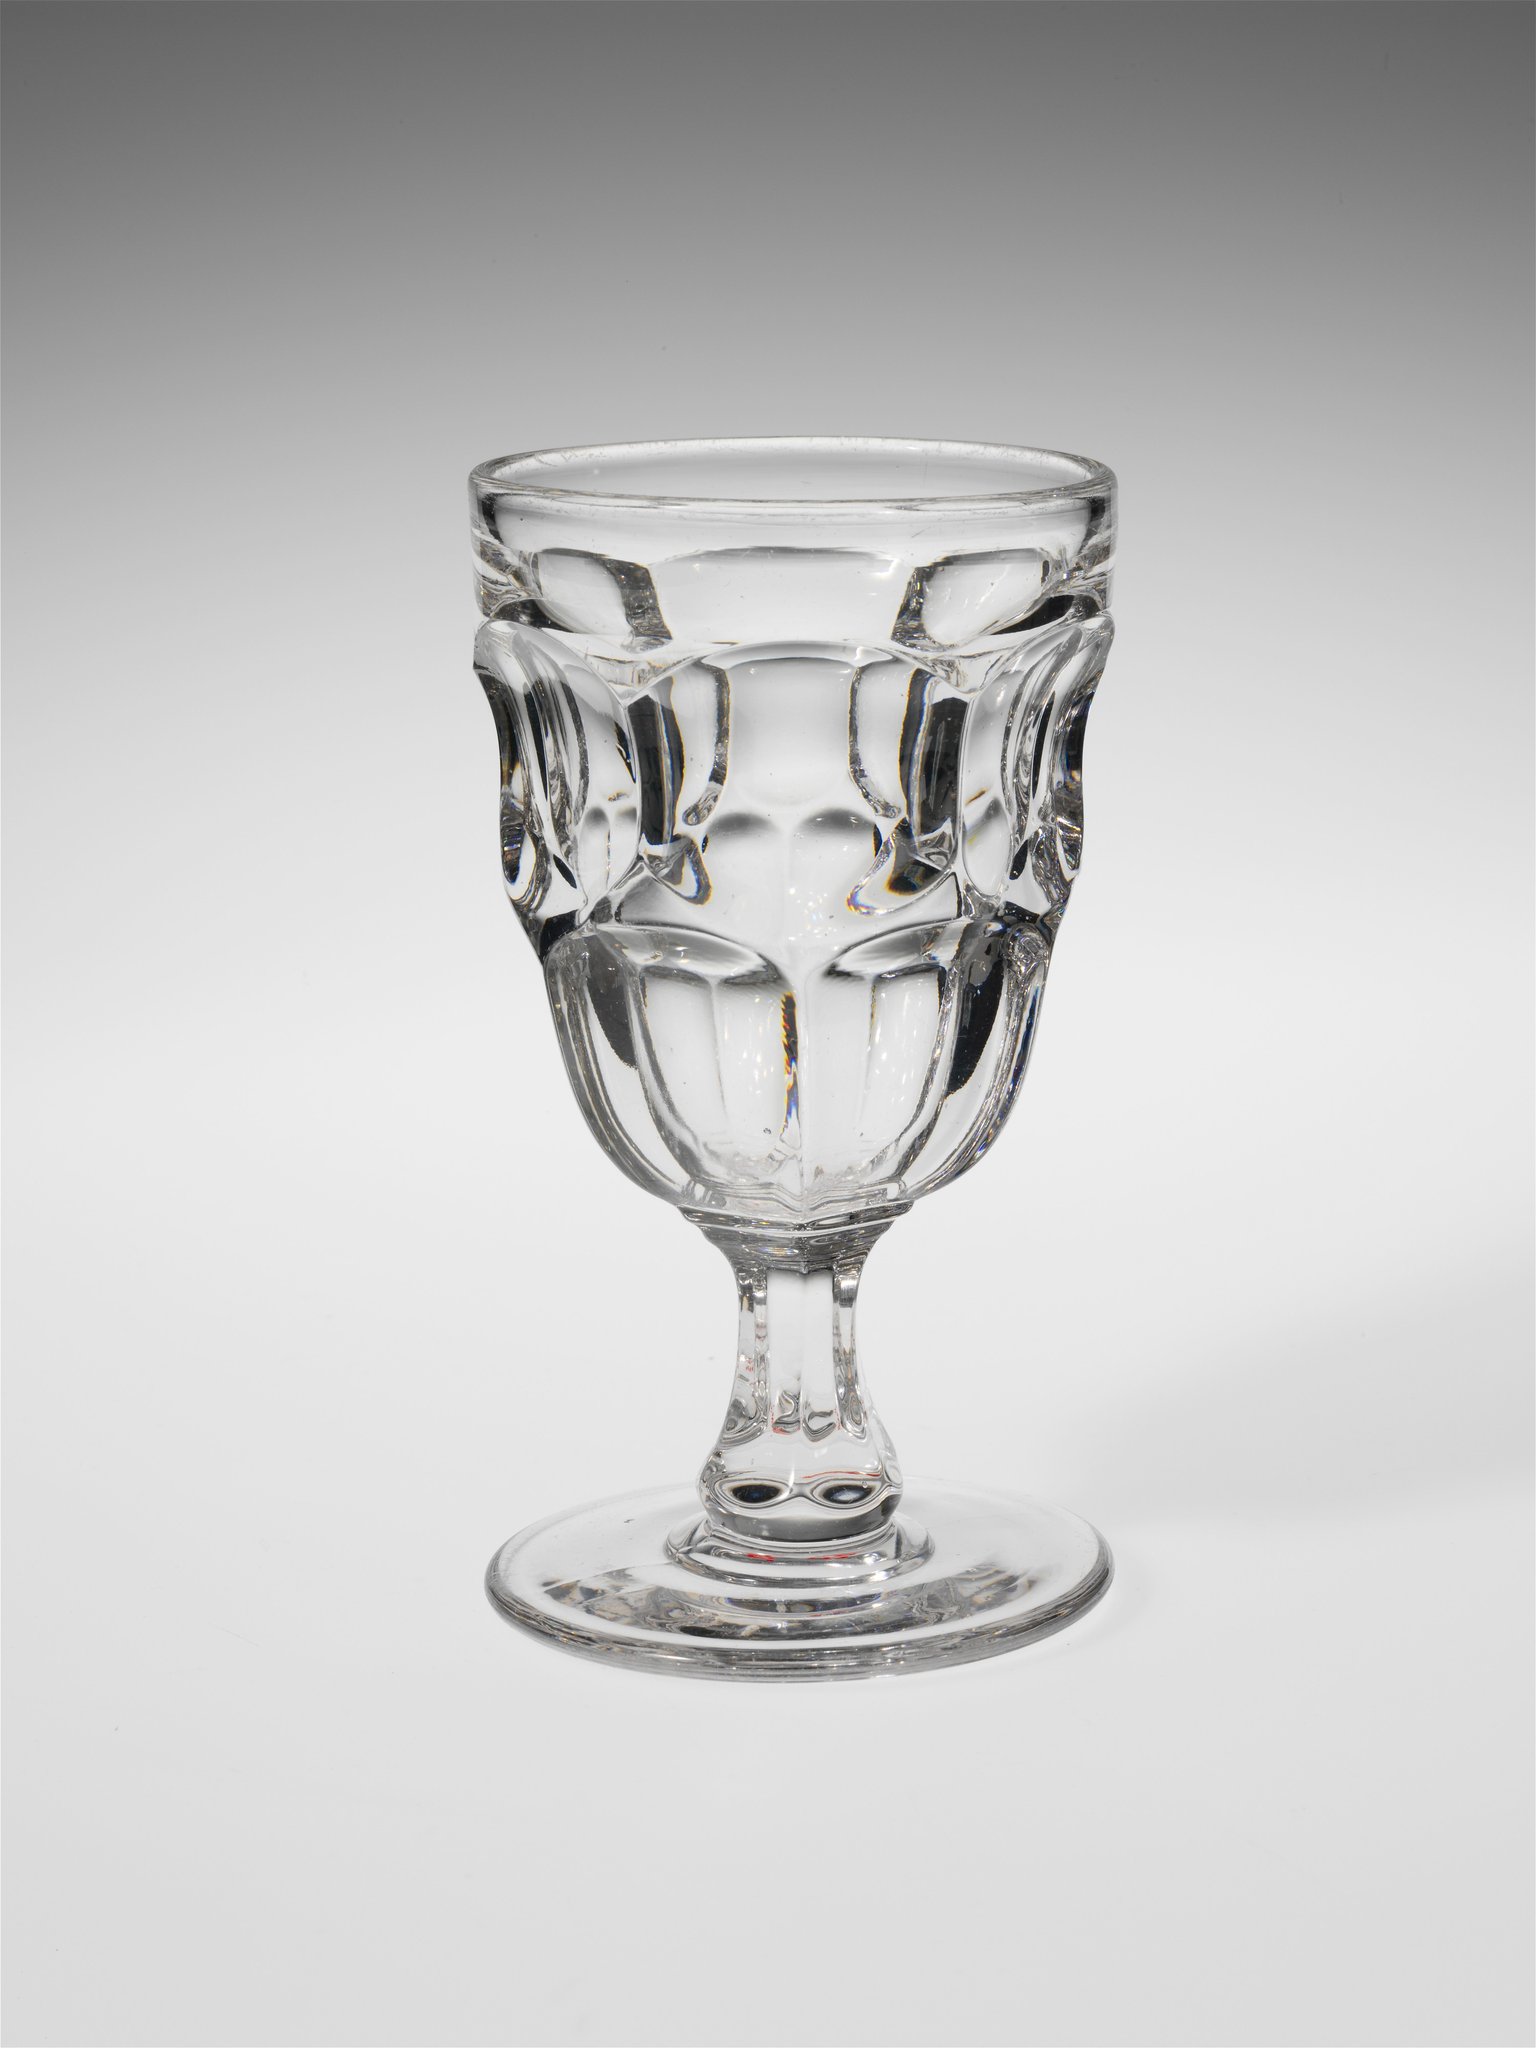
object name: goblet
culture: american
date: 1830-1870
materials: glass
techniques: pressed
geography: united states